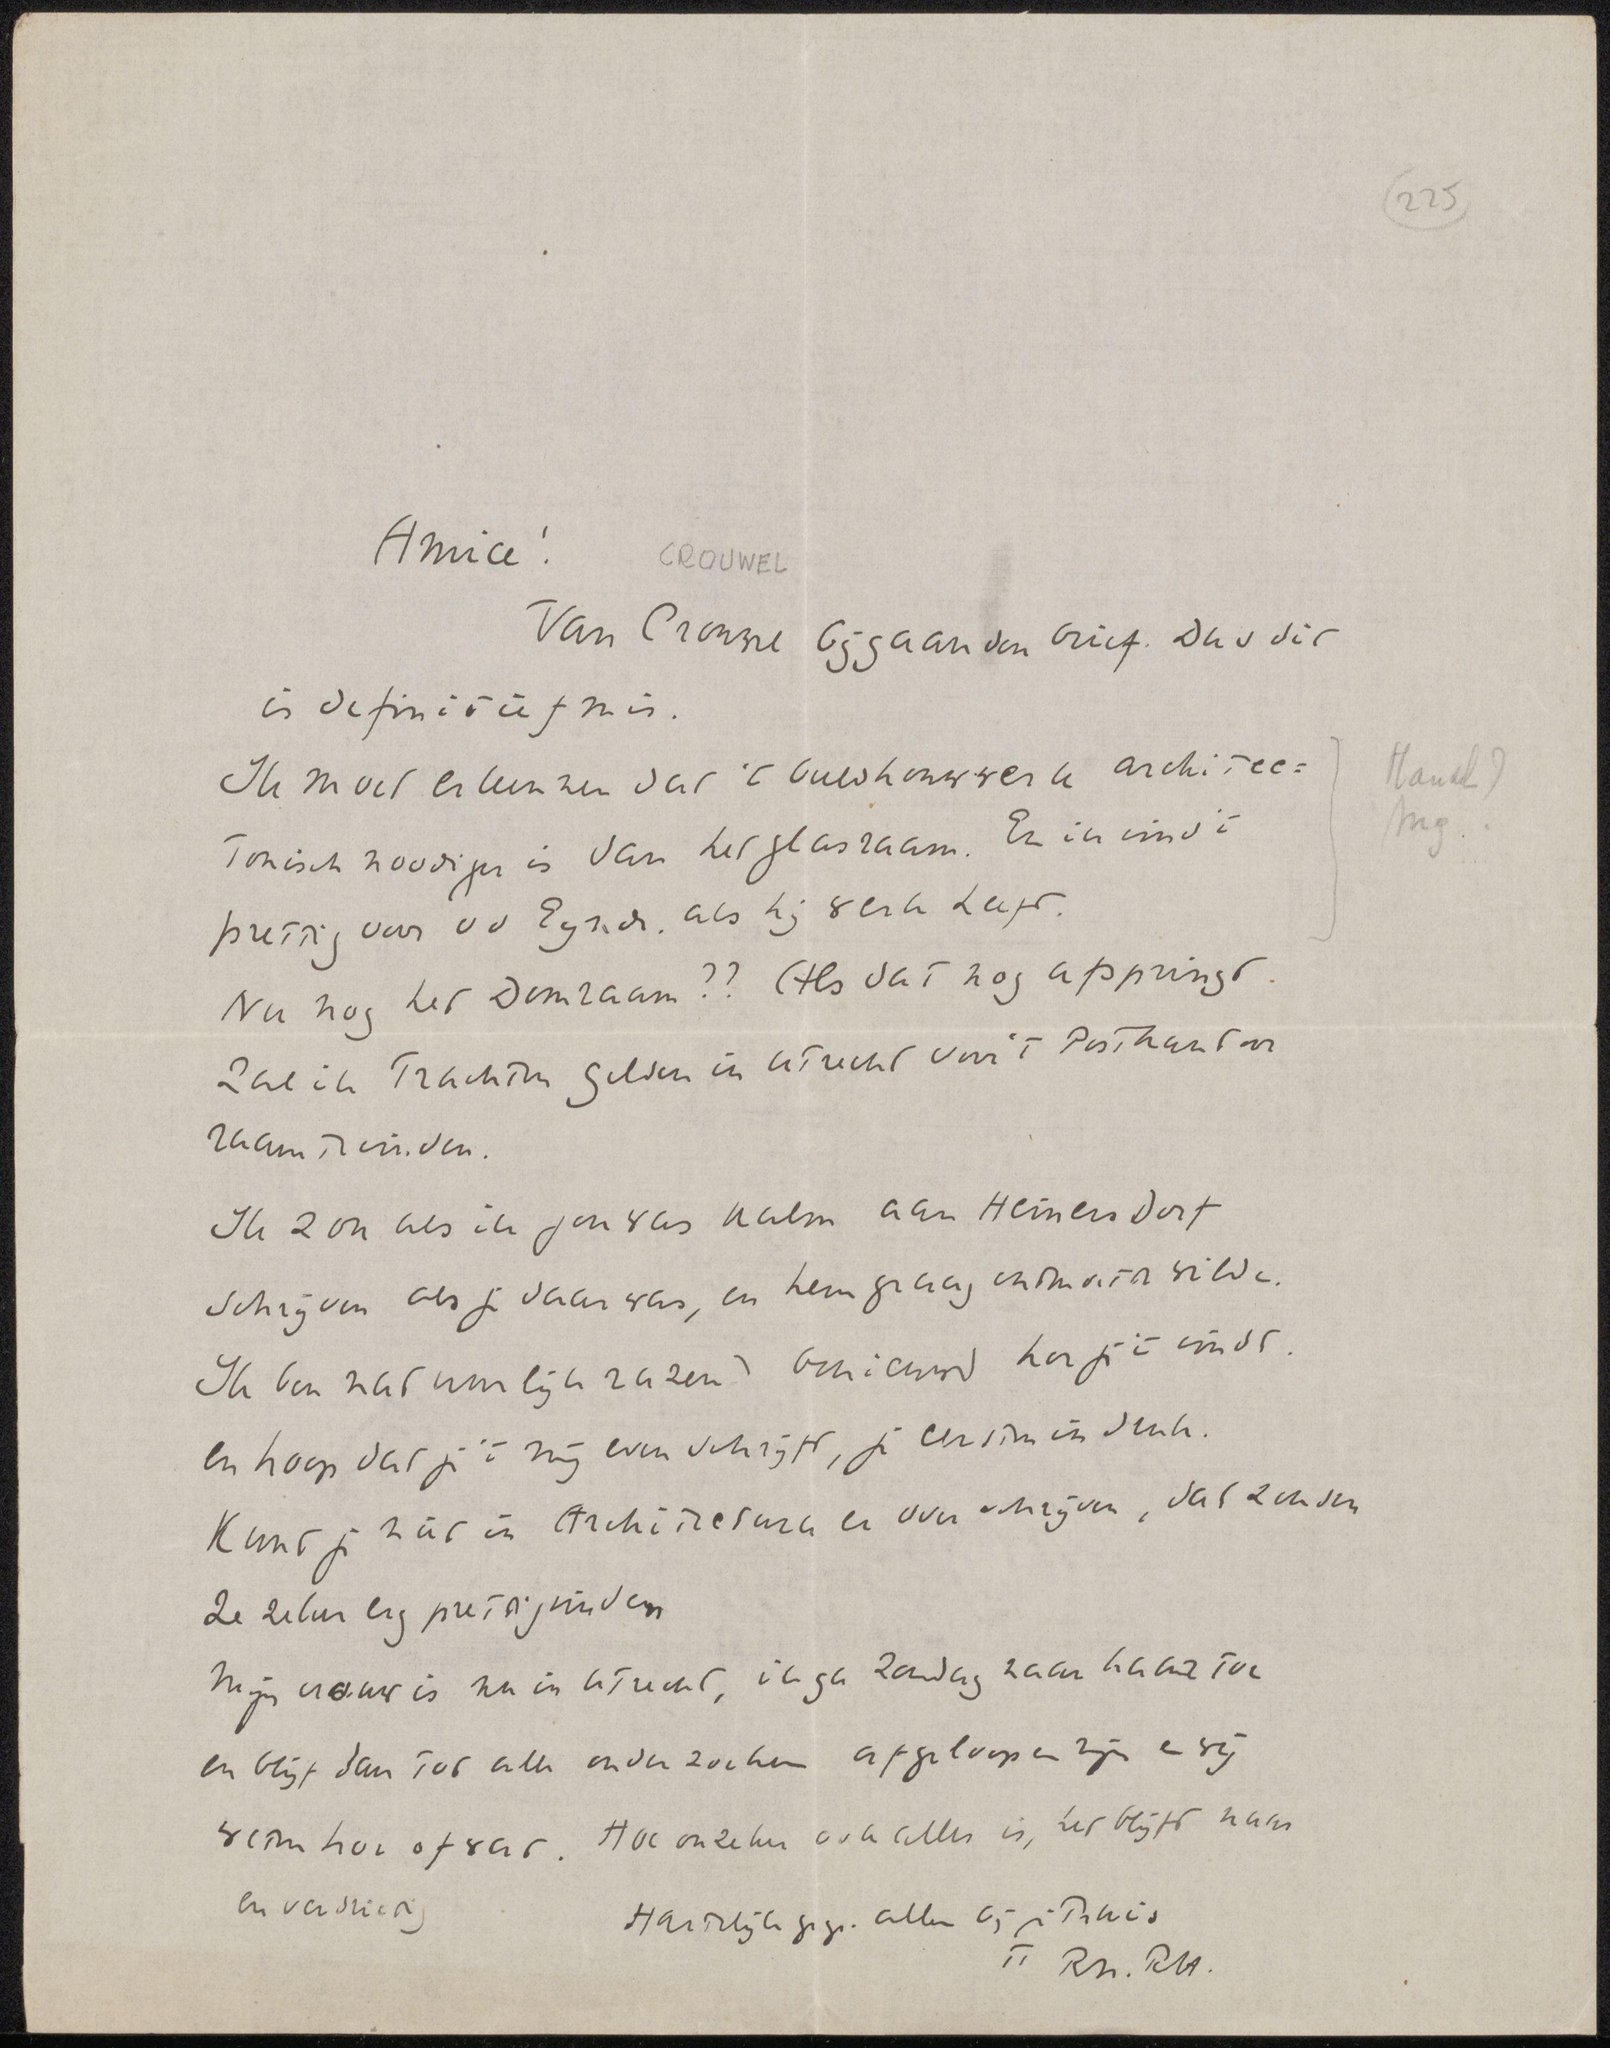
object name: letter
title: Brief aan Willem Bogtman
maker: richard nicolaüs roland holst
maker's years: 1868-1938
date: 1892-1938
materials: ink, paper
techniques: pen, writing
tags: haarlem, willem bogtman, utrecht, the hague, joseph crouwel, sculptor, hendrik albertus van den eijnde, henriëtte roland holst-van der schalk, applied arts, arts and crafts; industrial design, sculpture, money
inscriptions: watermark